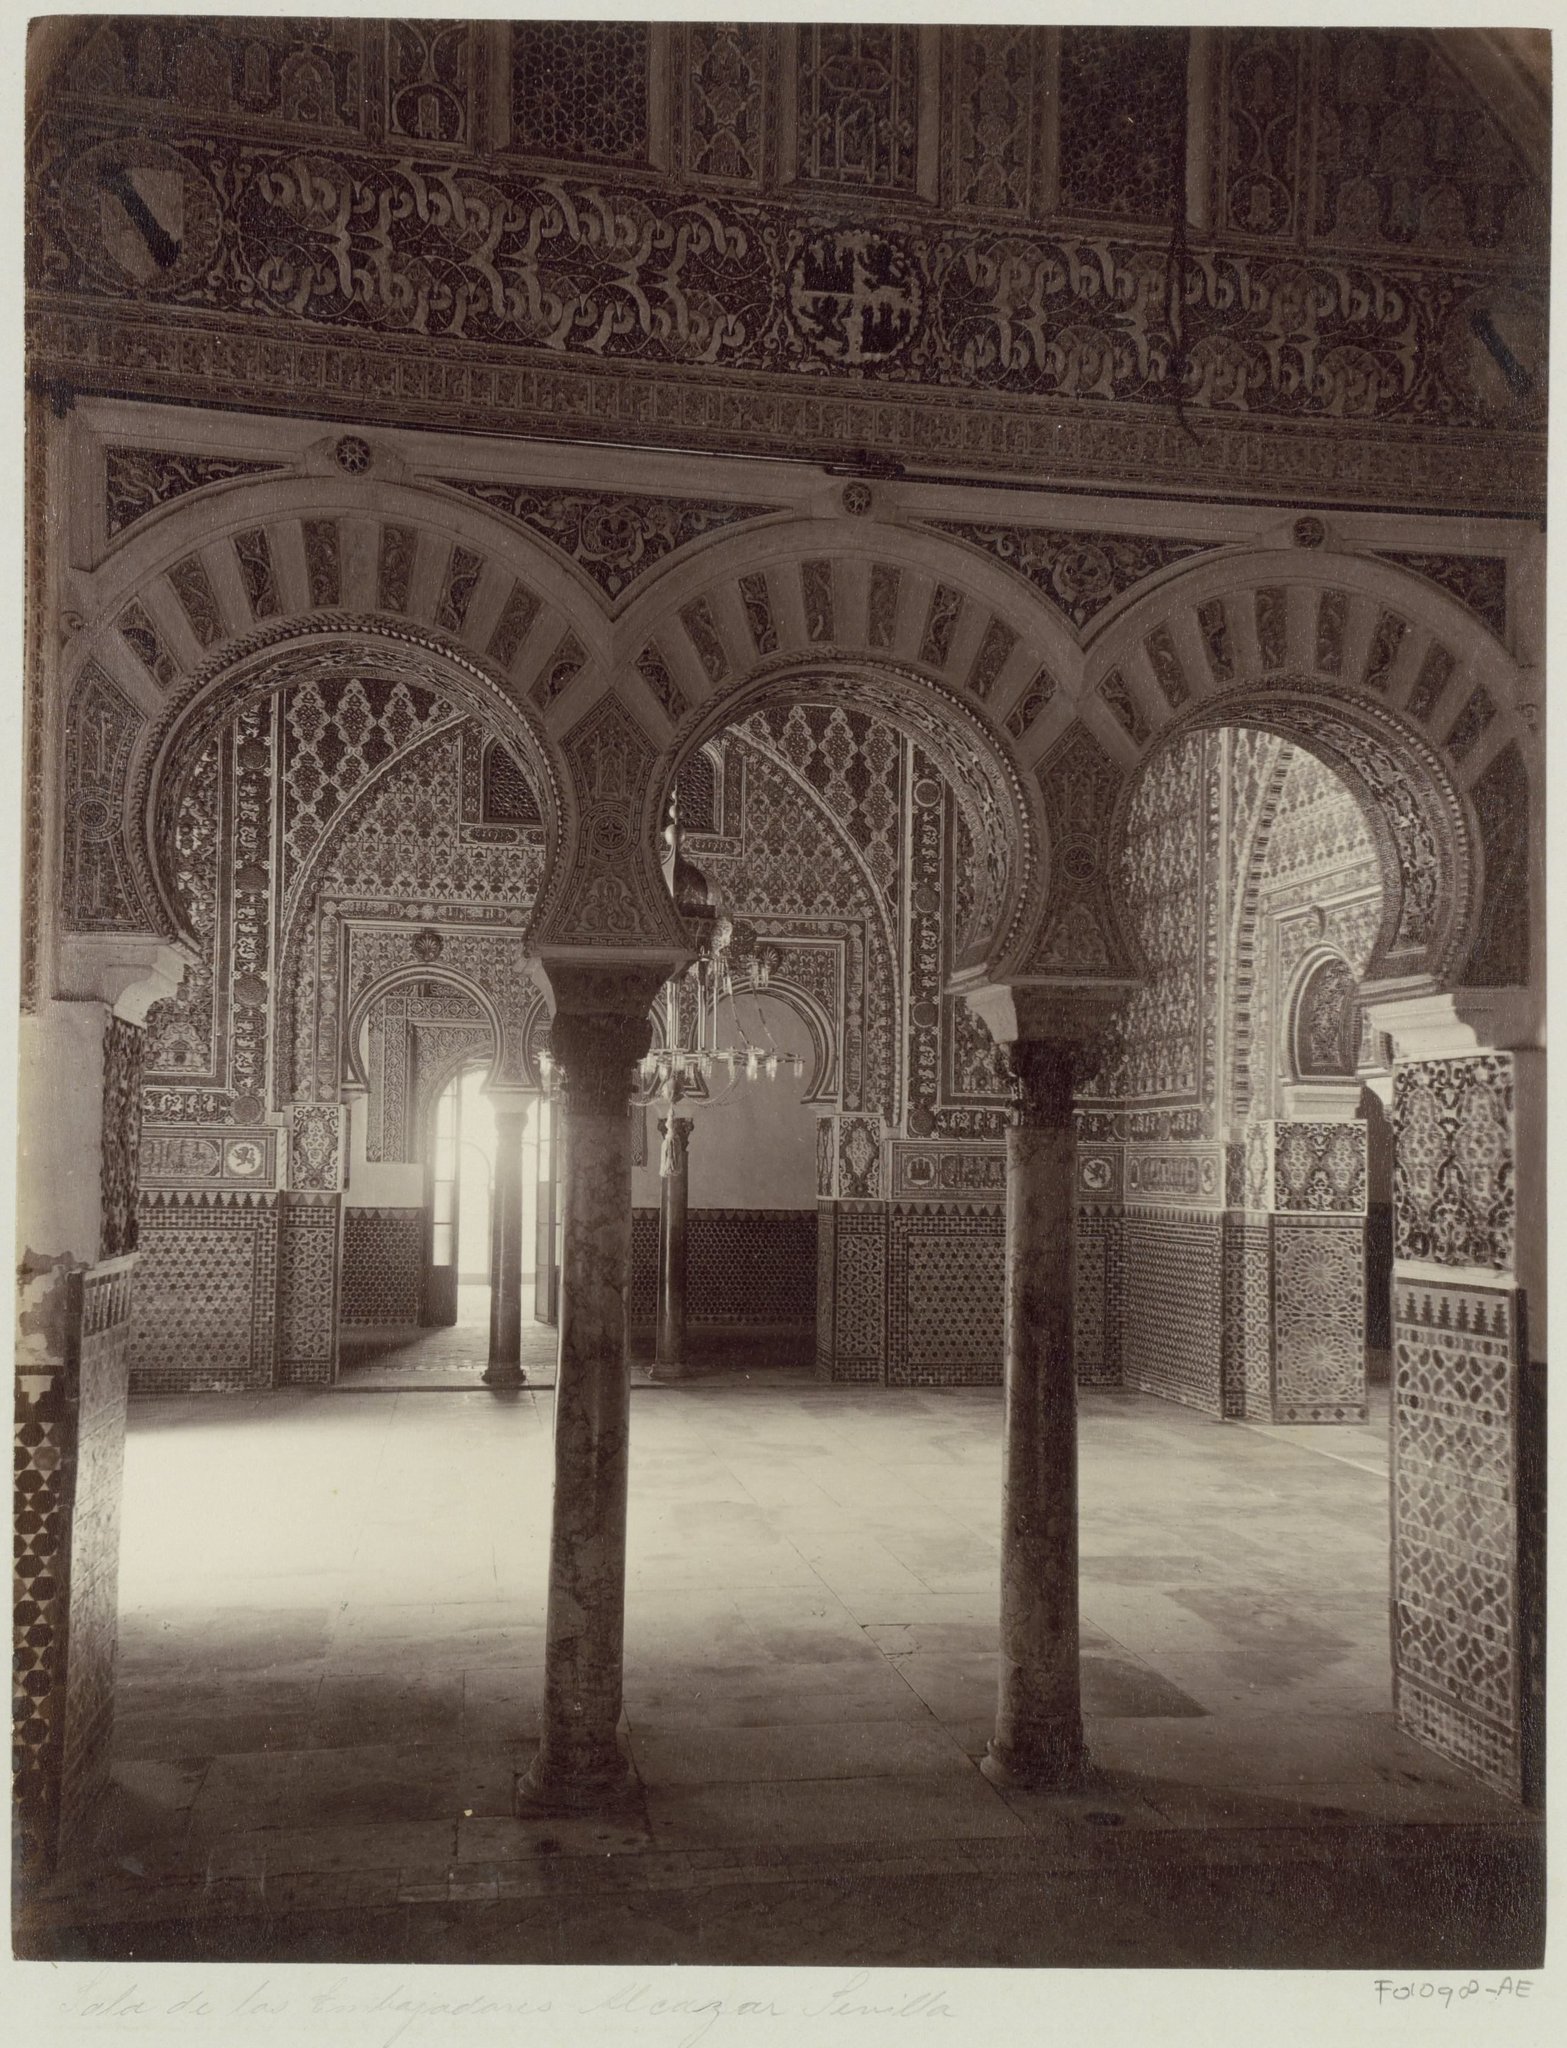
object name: photograph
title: Sevilla, Alcazar, Sala de los Ambajadores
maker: Anonymous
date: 1860-1880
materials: cardboard, paper, photographic support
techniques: albumen print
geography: royal palace of seville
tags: palace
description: Onderdeel van Reisalbum met foto's van bezienswaardigheden in Spanje en Marokko.